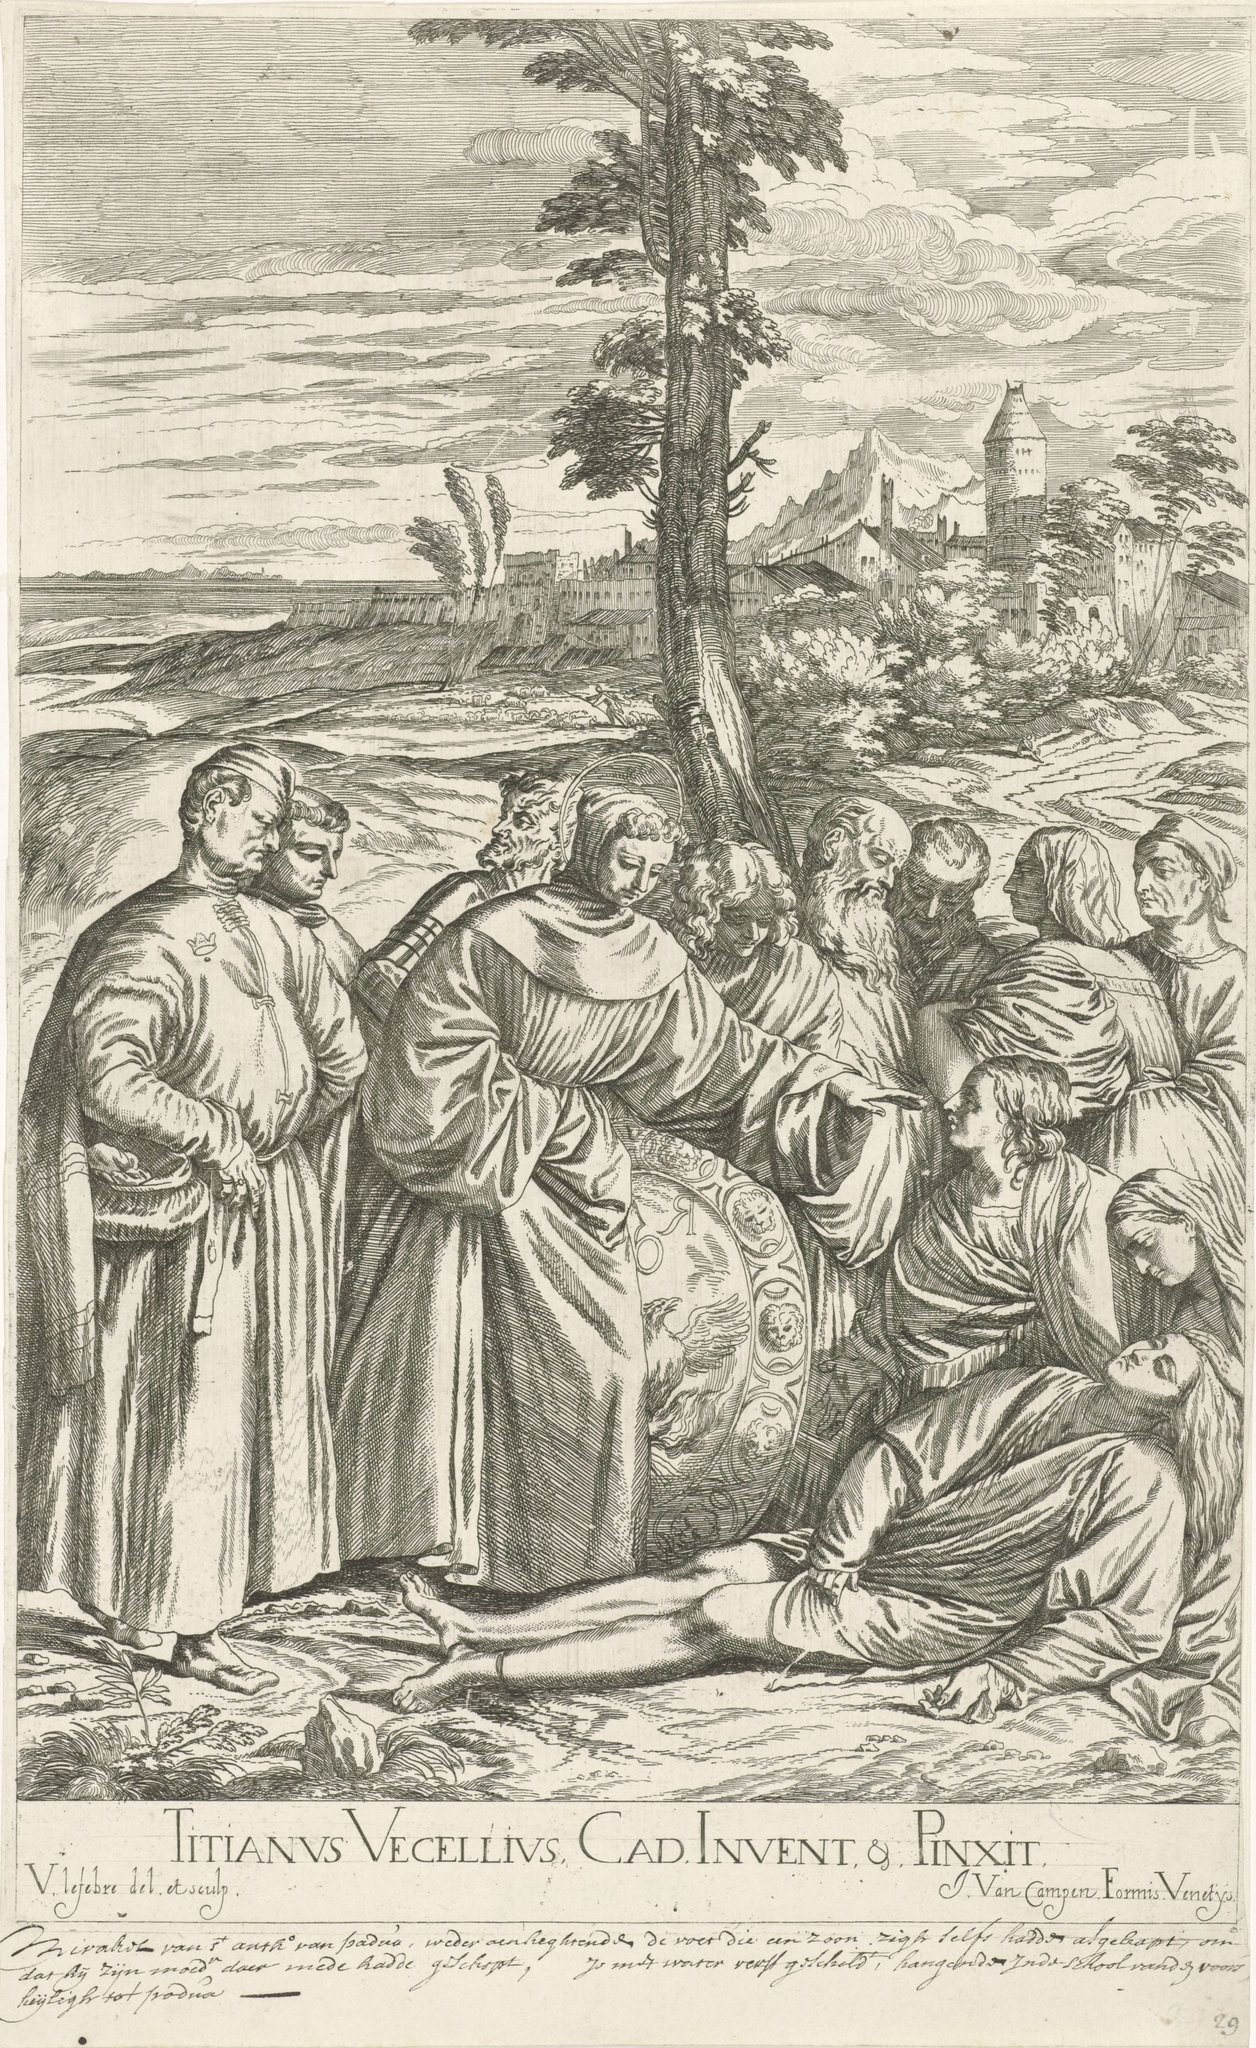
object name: print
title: Opera Selectiora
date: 1682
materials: paper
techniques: etching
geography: venice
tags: the healing of the wrathful son: a young man who had cut off his leg in remorse after kicking his mother, had it miraculously restored by st. antony of padua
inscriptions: number: ‘29’, collector's mark: Lugt 240, inscription: ‘Mirakel van [...] tot Padua’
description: In een landschap laat de H. Antonius van Padua op wonderbaarlijke wijze het been van een op de grond gelegen jongeman weer aangroeien. De jongeman sneed zijn voet in een aanval van berouw af nadat hij zijn moeder had geschopt. Verschillende omstanders kijken toe hoe dit mirakel zich voltrekt. De prent maakt deel uit van een 53-delige serie prenten naar schilderijen van Titiaan en Veronese.